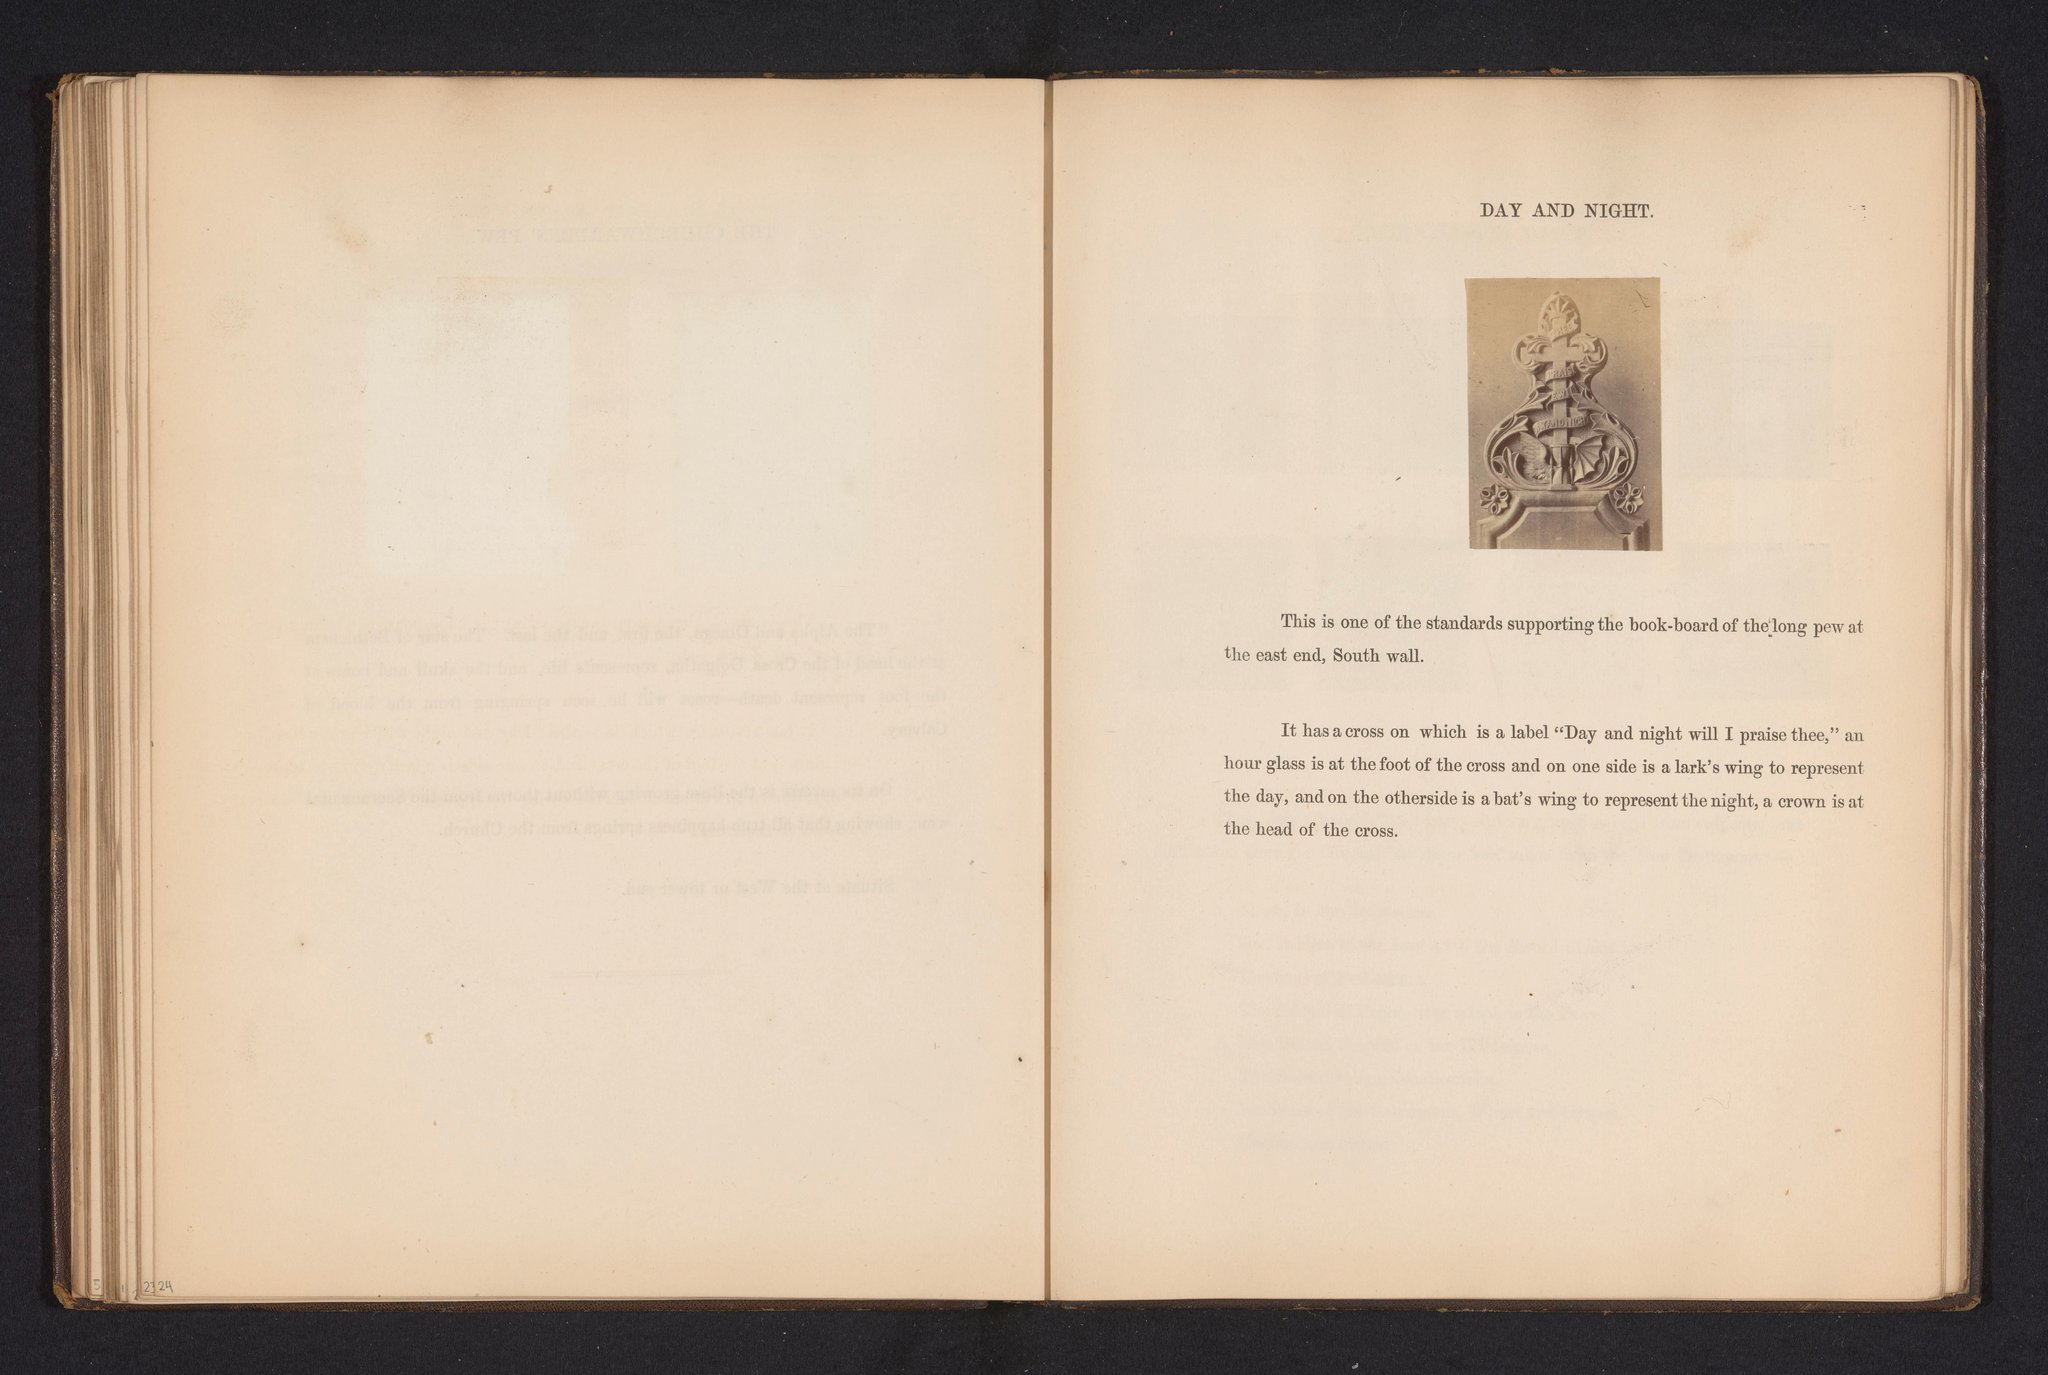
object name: page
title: Decoratie van een kerkbank in de St Michael in Cornhill, voorstellend dag en nacht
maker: Anonymous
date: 1857-1867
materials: photographic support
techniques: albumen print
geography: st michael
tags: bench, the cross ~ symbols of christ, hourglass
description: Dag en nacht zijn verbeeld door een zandloper en de tekst: Day and night will I praise thee.